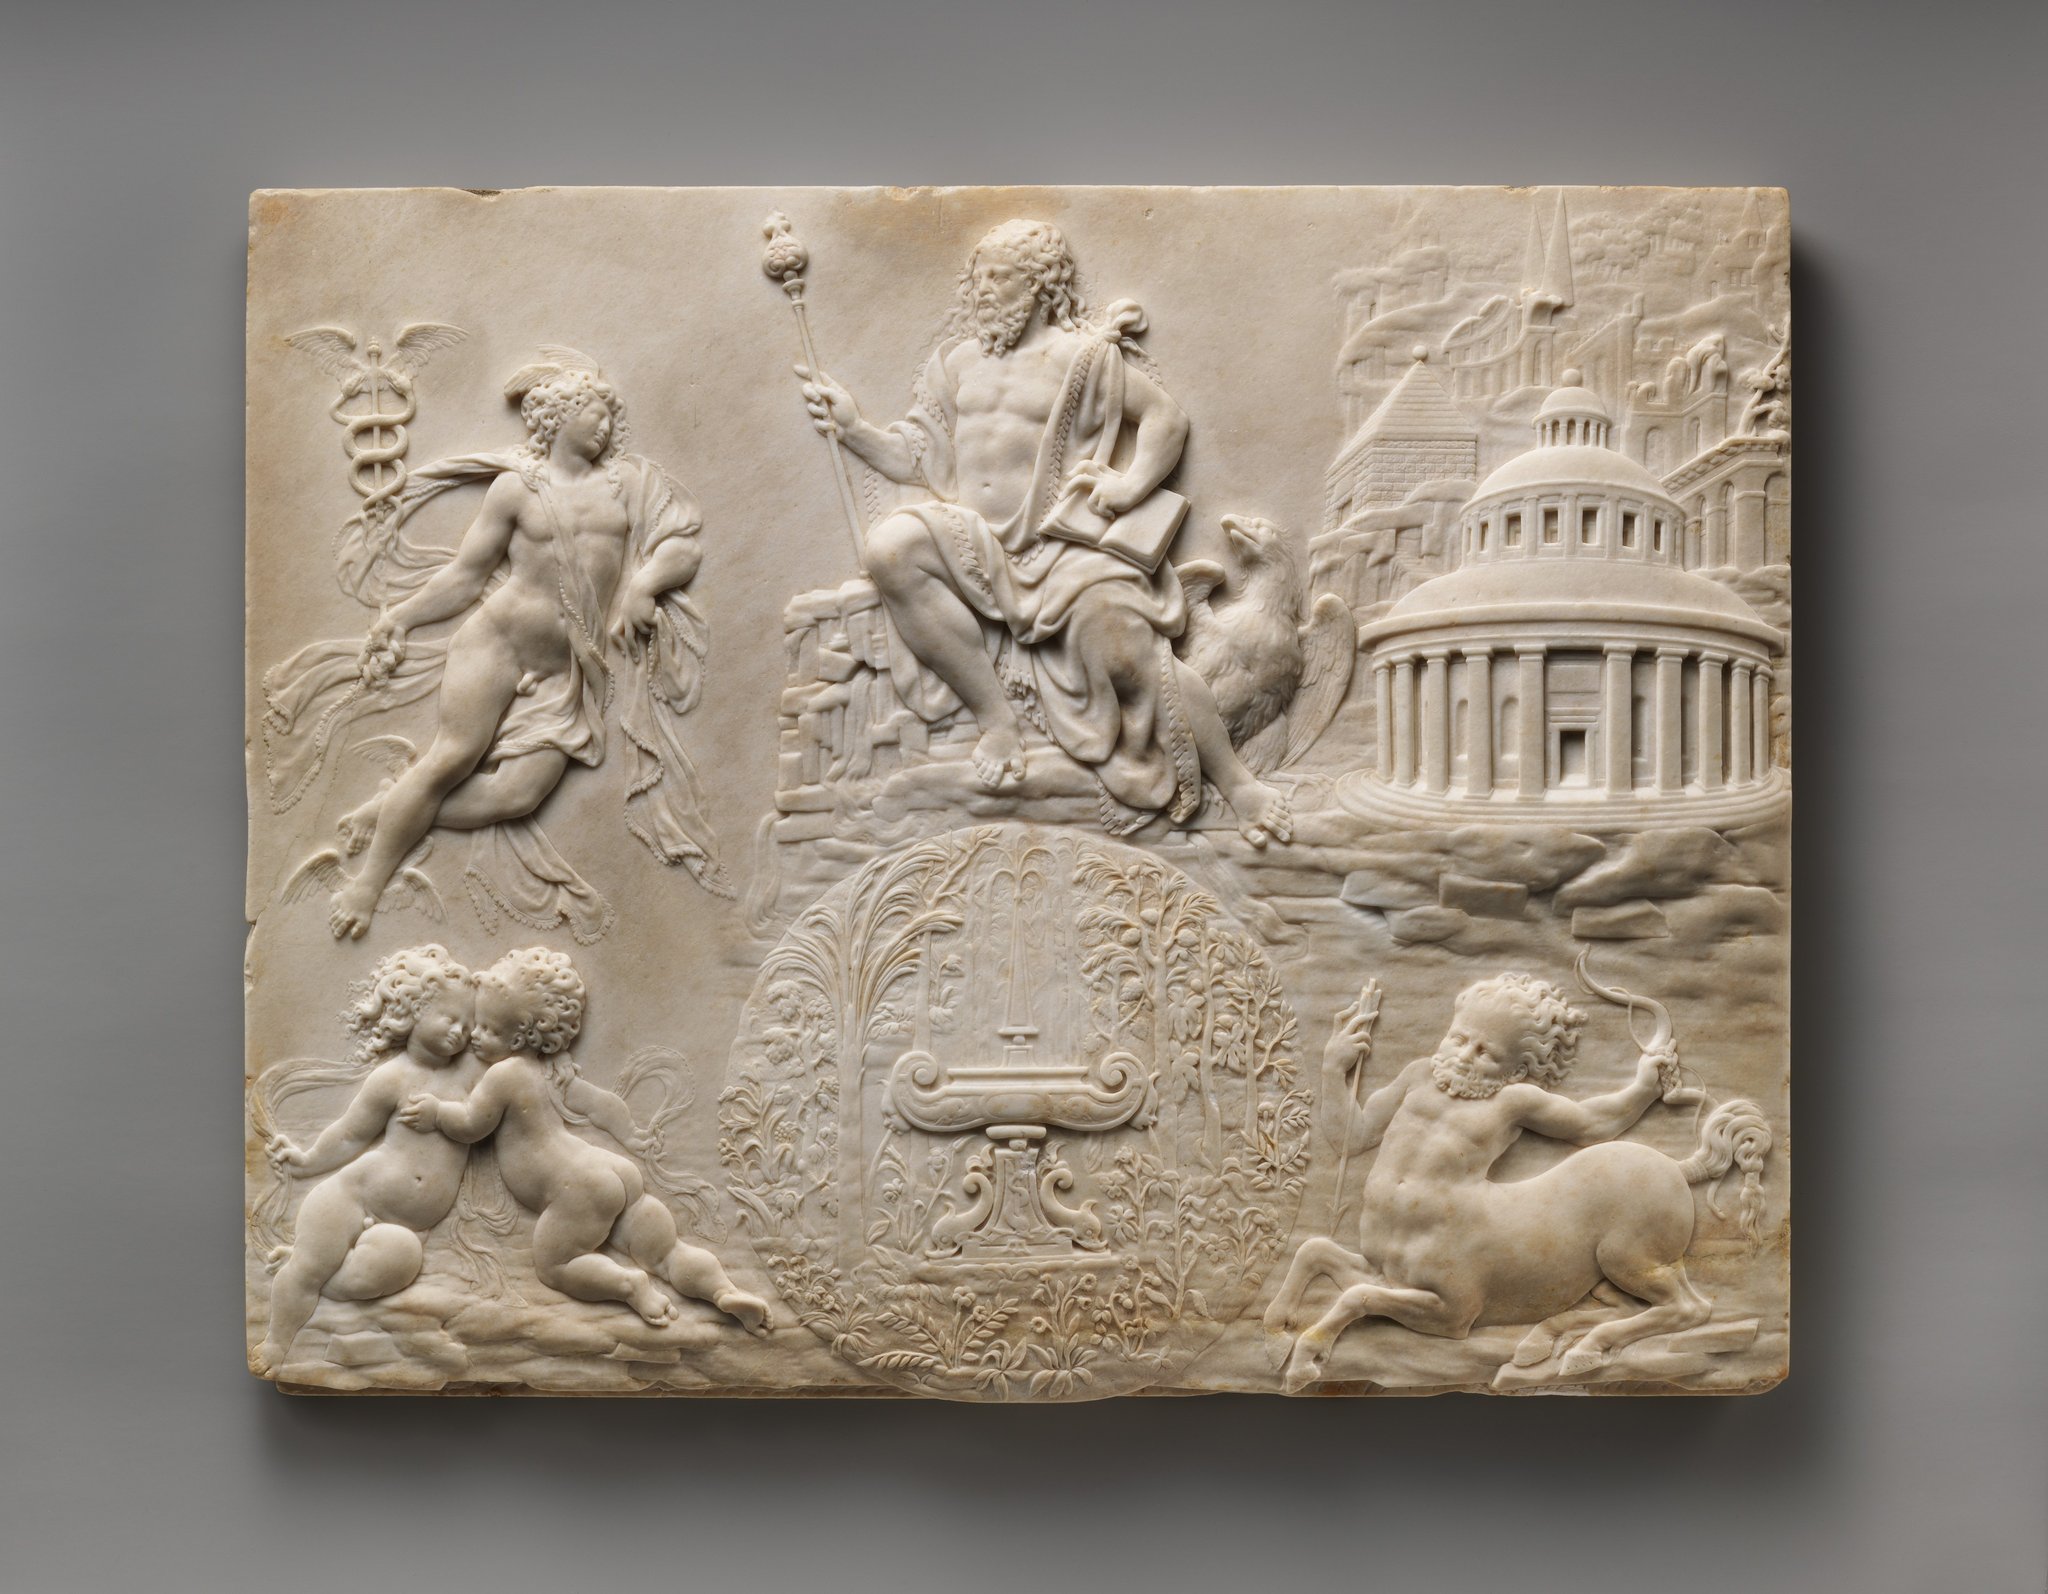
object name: relief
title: The Reign of Jupiter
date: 1550-1570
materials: marble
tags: eagles,buildings,male nudes,centaurs,jupiter